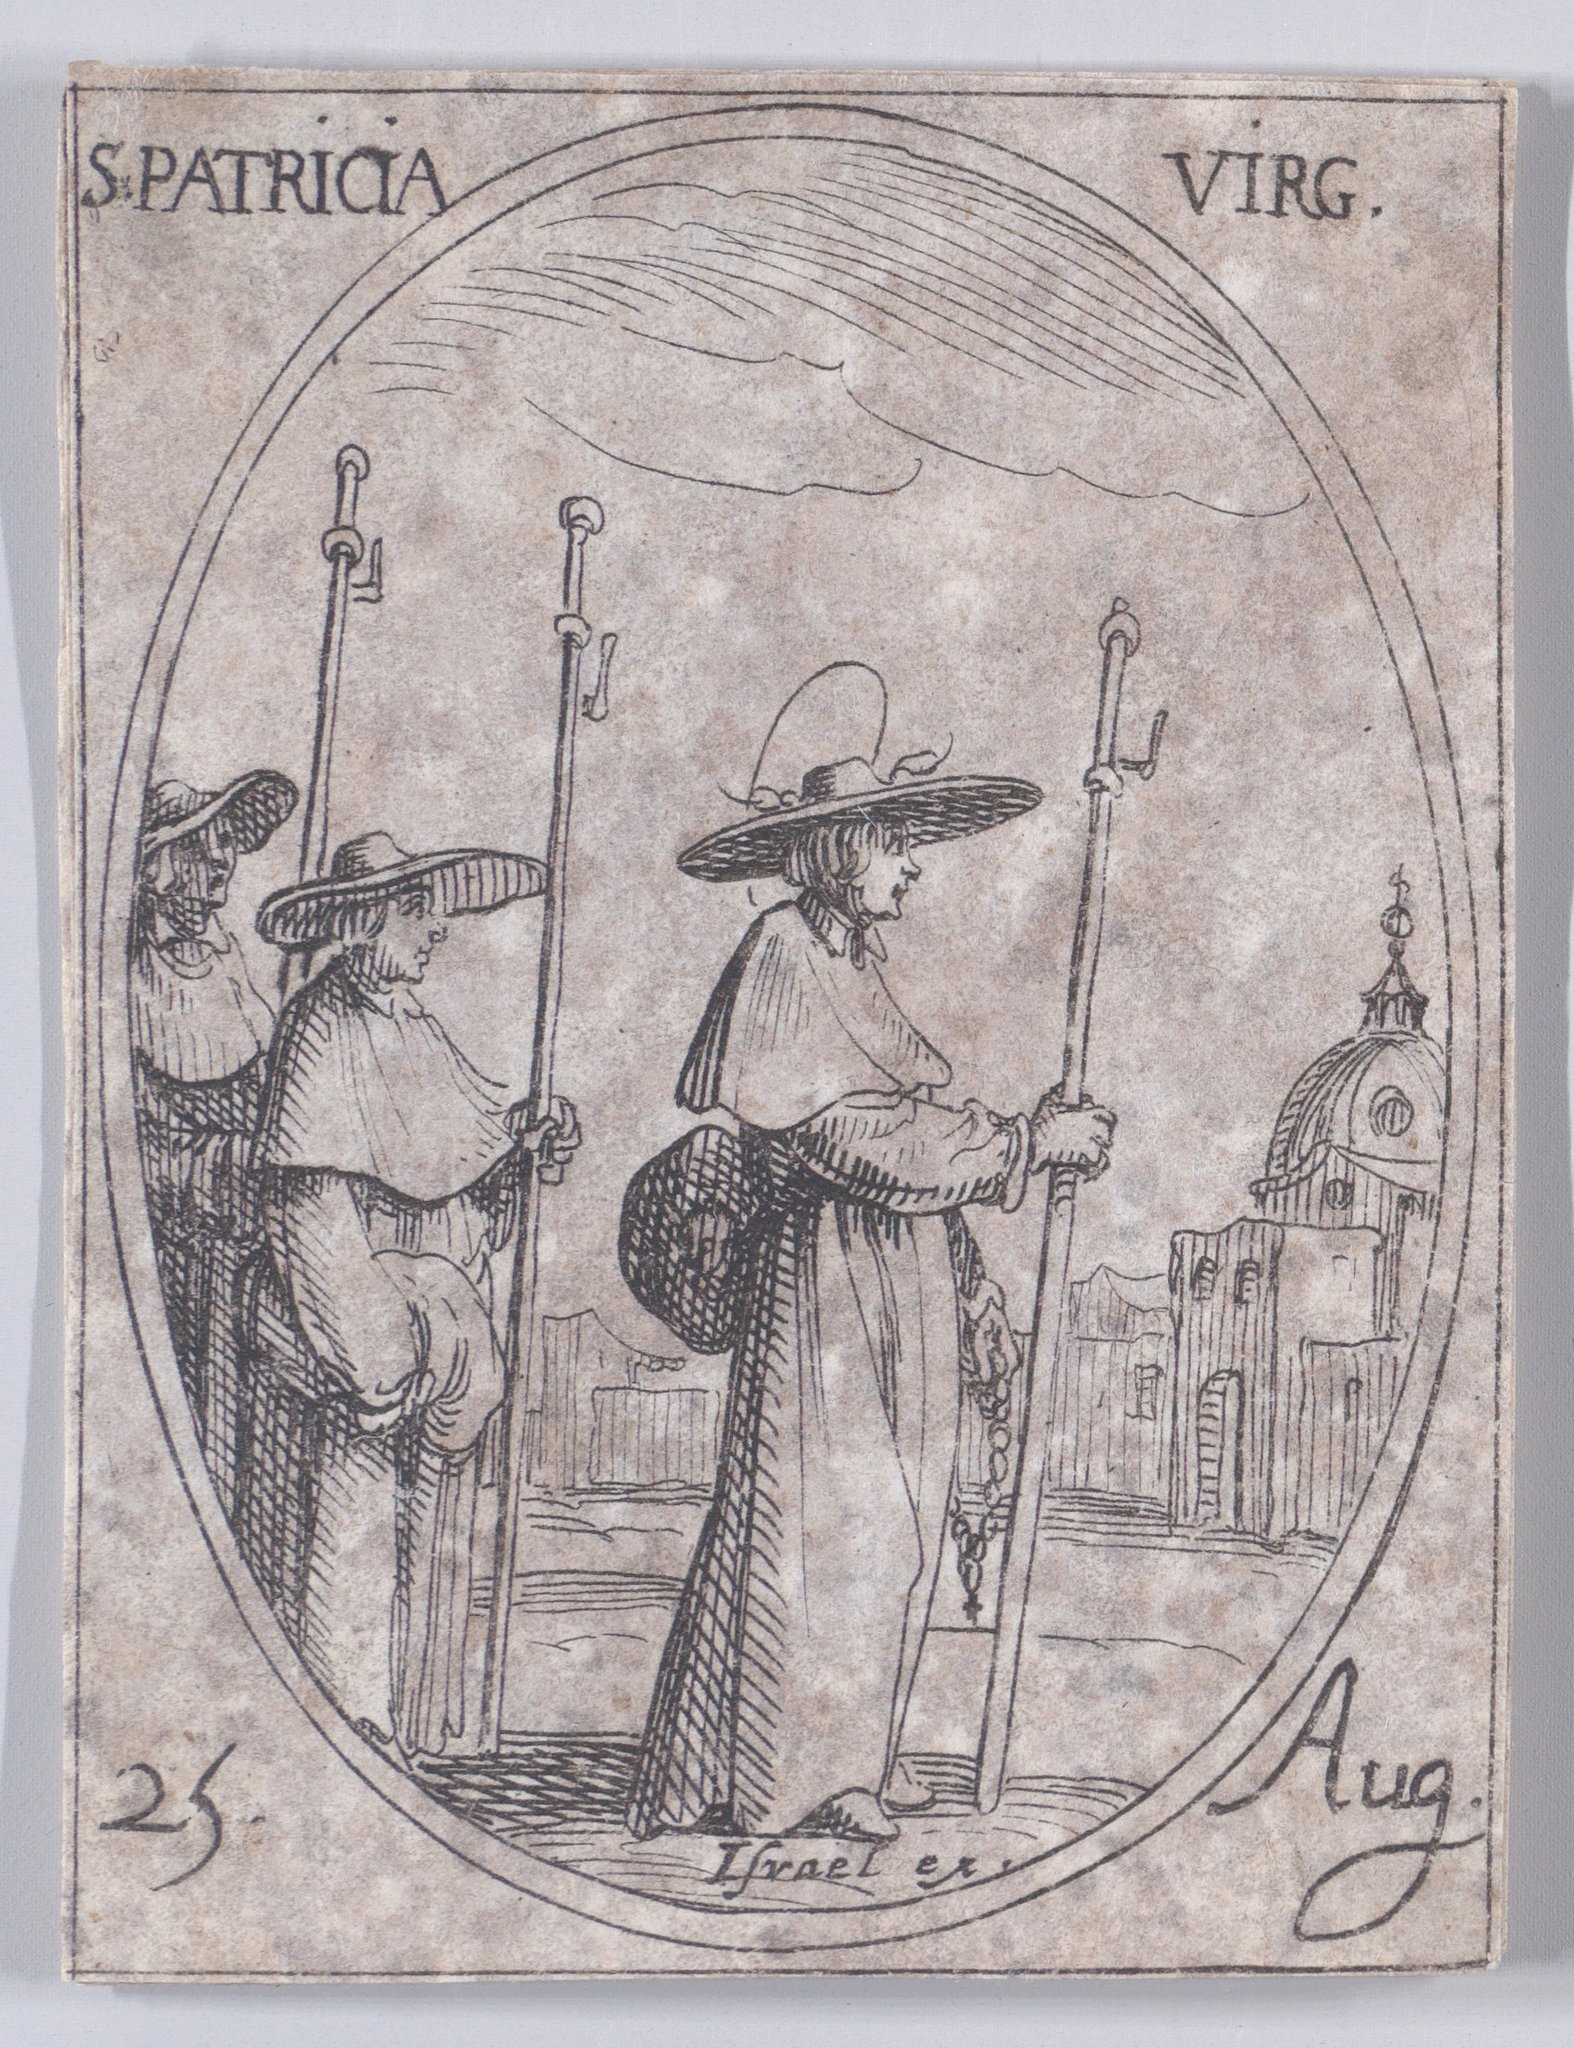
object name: print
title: S. Patrice, vierge (St. Patricia, Virgin), August 25th, from "Les Images De Tous Les Saincts et Saintes de L'Année" (Images of All of the Saints and Religious Events of the Year)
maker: jacques callot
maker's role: artist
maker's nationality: french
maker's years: 1592-1635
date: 1636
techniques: etching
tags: saints